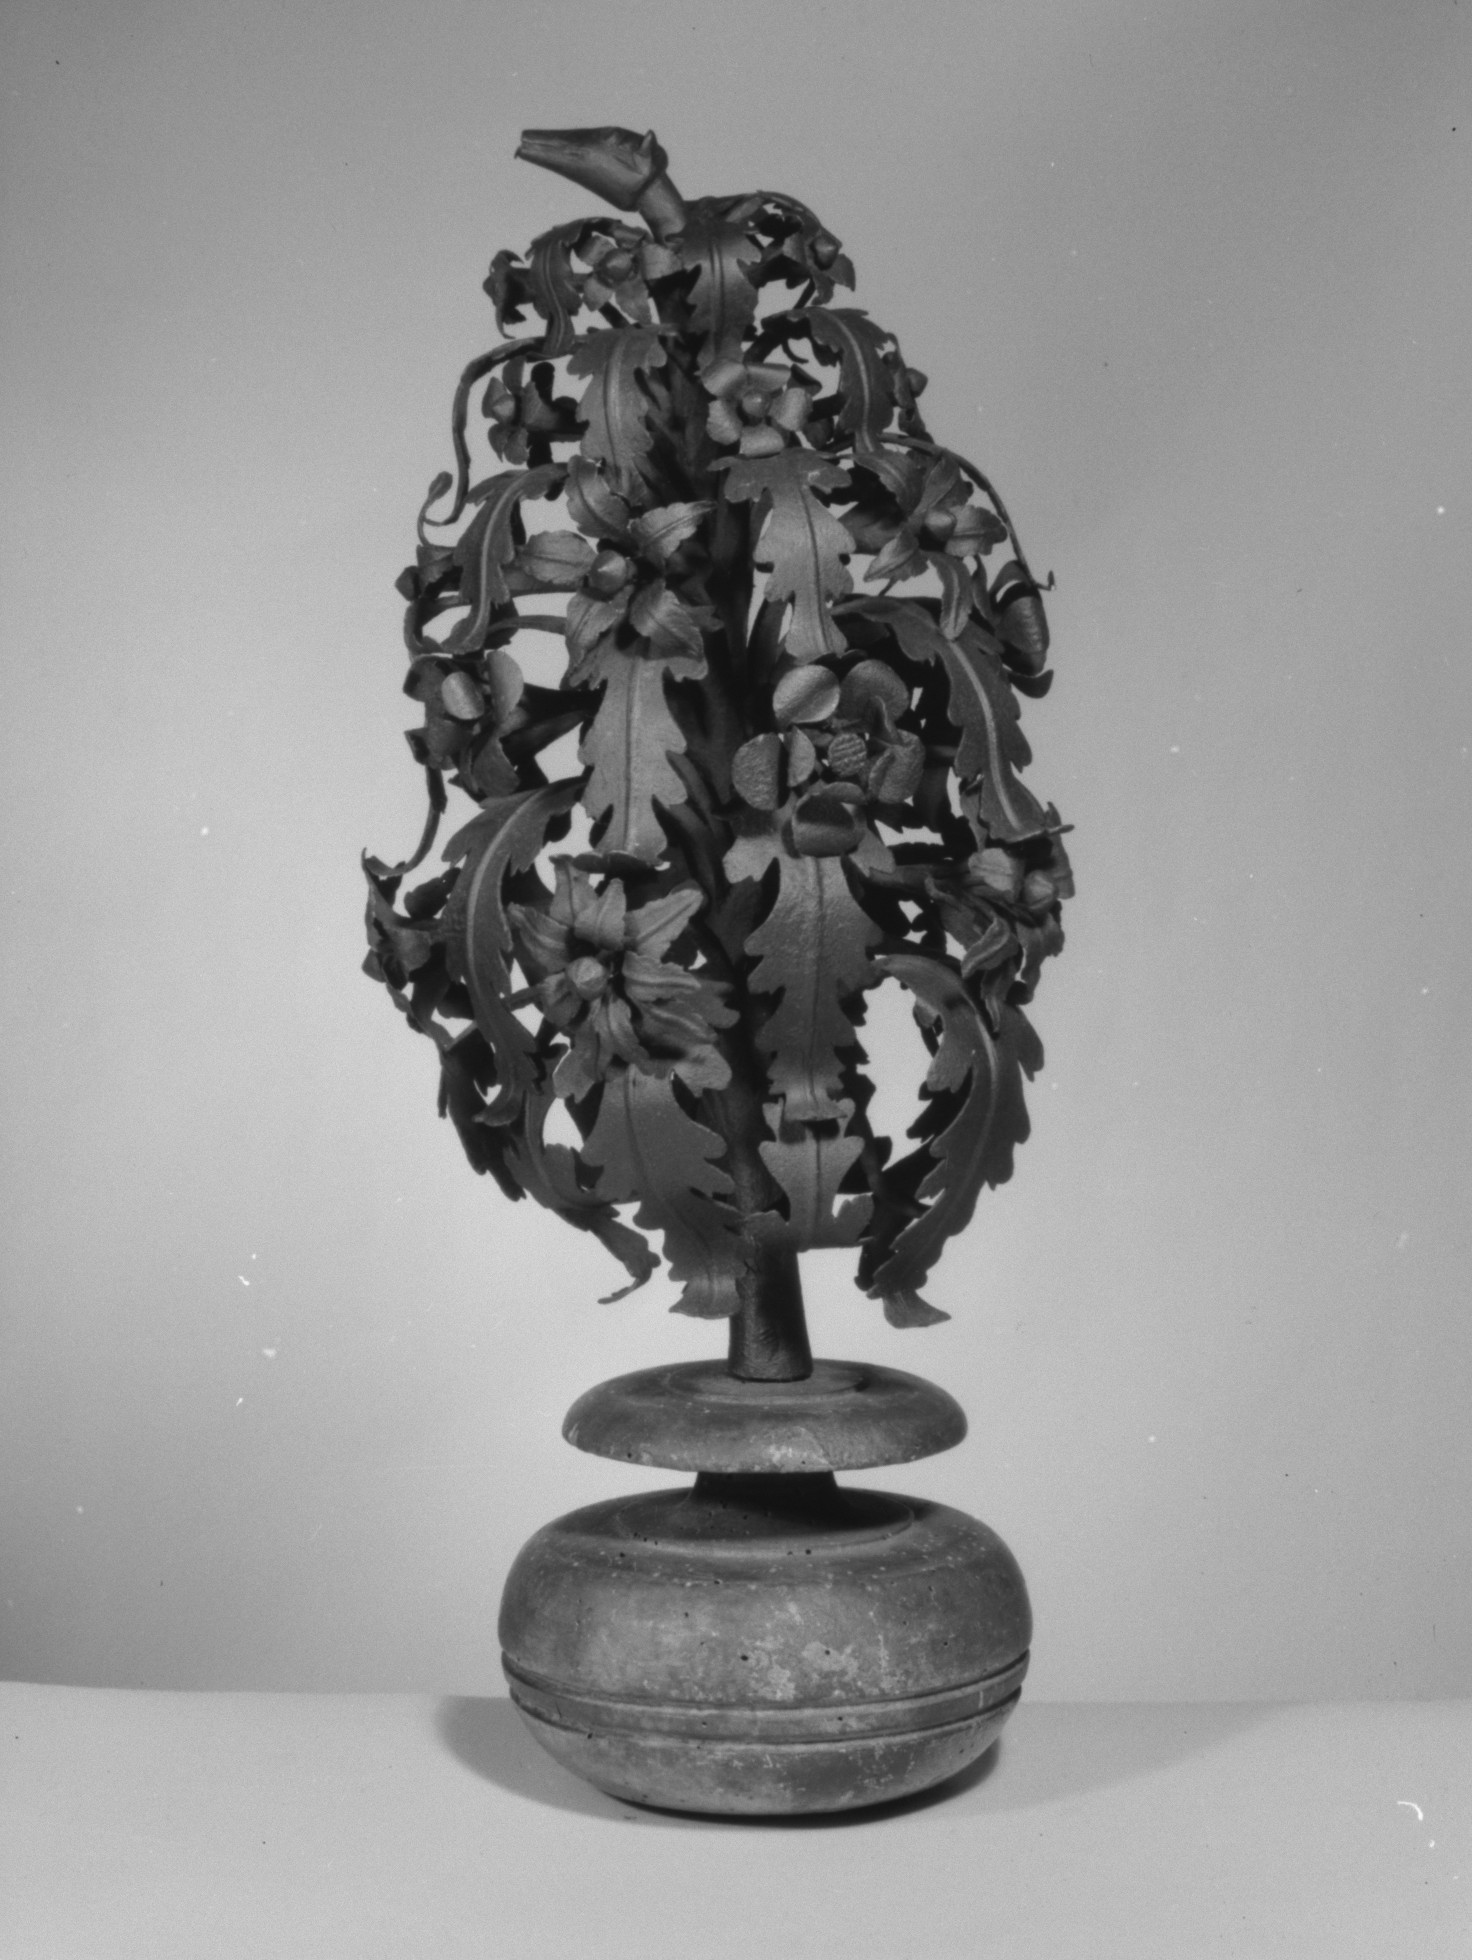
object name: finial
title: Pair of finials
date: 1601-1700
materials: iron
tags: plants